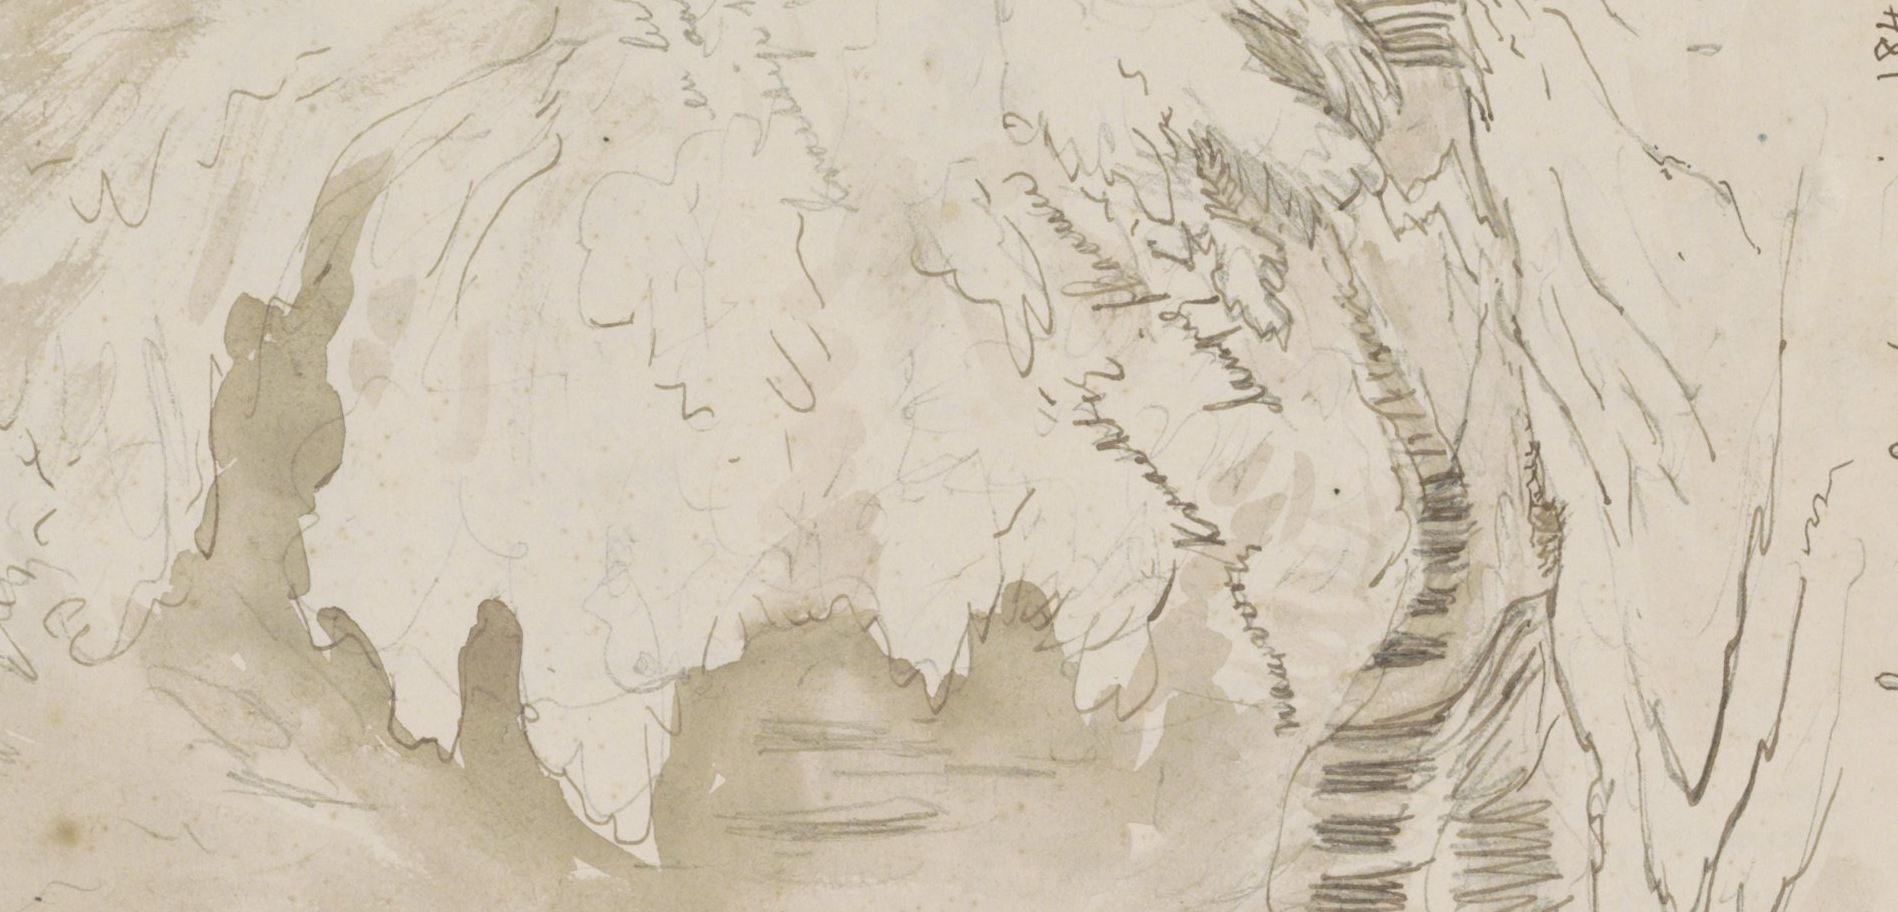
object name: sketchbook leaf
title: Laan Cleverberg, bij het atelier van de kunstenaar in Kleef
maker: johannes tavenraat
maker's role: draughtsman, painter, print maker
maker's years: 1809-1881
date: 1848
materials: ink, paper, pencil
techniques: pen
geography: cleves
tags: forest path or lane, cleves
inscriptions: signature and date: ‘Laan Cleverberg in 1848/ bij mijne Atelier Tevenraat’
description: Blad 16 recto uit een schetsboek met 63 bladen.